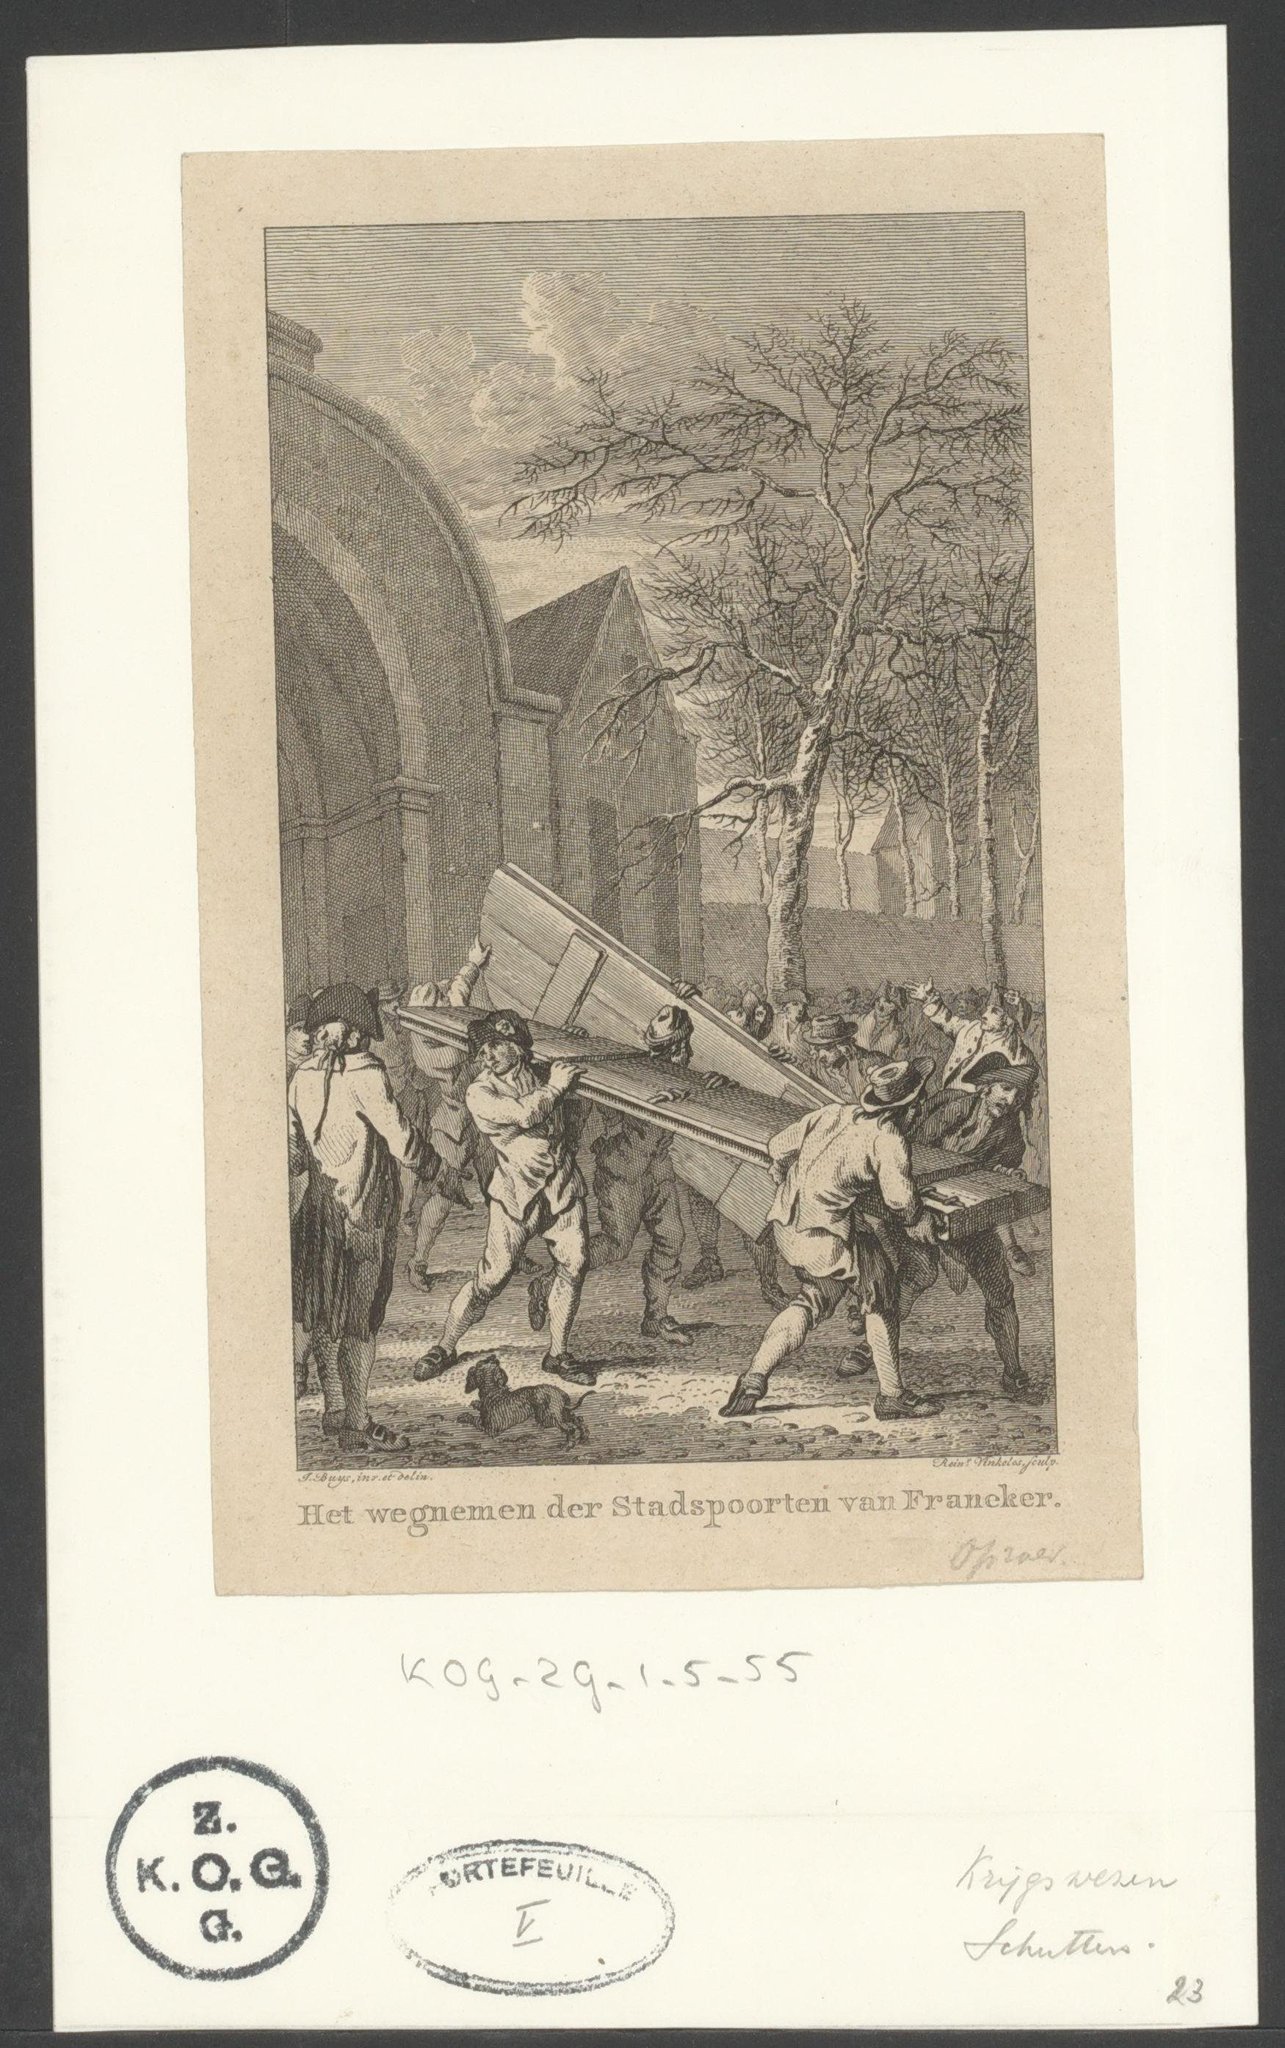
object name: print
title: Het wegnemen der Stadspoorten van Franeker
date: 1797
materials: paper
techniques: engraving, etching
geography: amsterdam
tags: fire-extinguishing equipment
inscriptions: collector's mark: Lugt 1641, stamp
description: Het wegnemen van de deuren van de stadspoort van Franeker, februari 1788. Onderwerpsrubrieken binnen de Atlas Zeden en Gewoonten: Krijgswezen, Schutterij, Historieprenten.